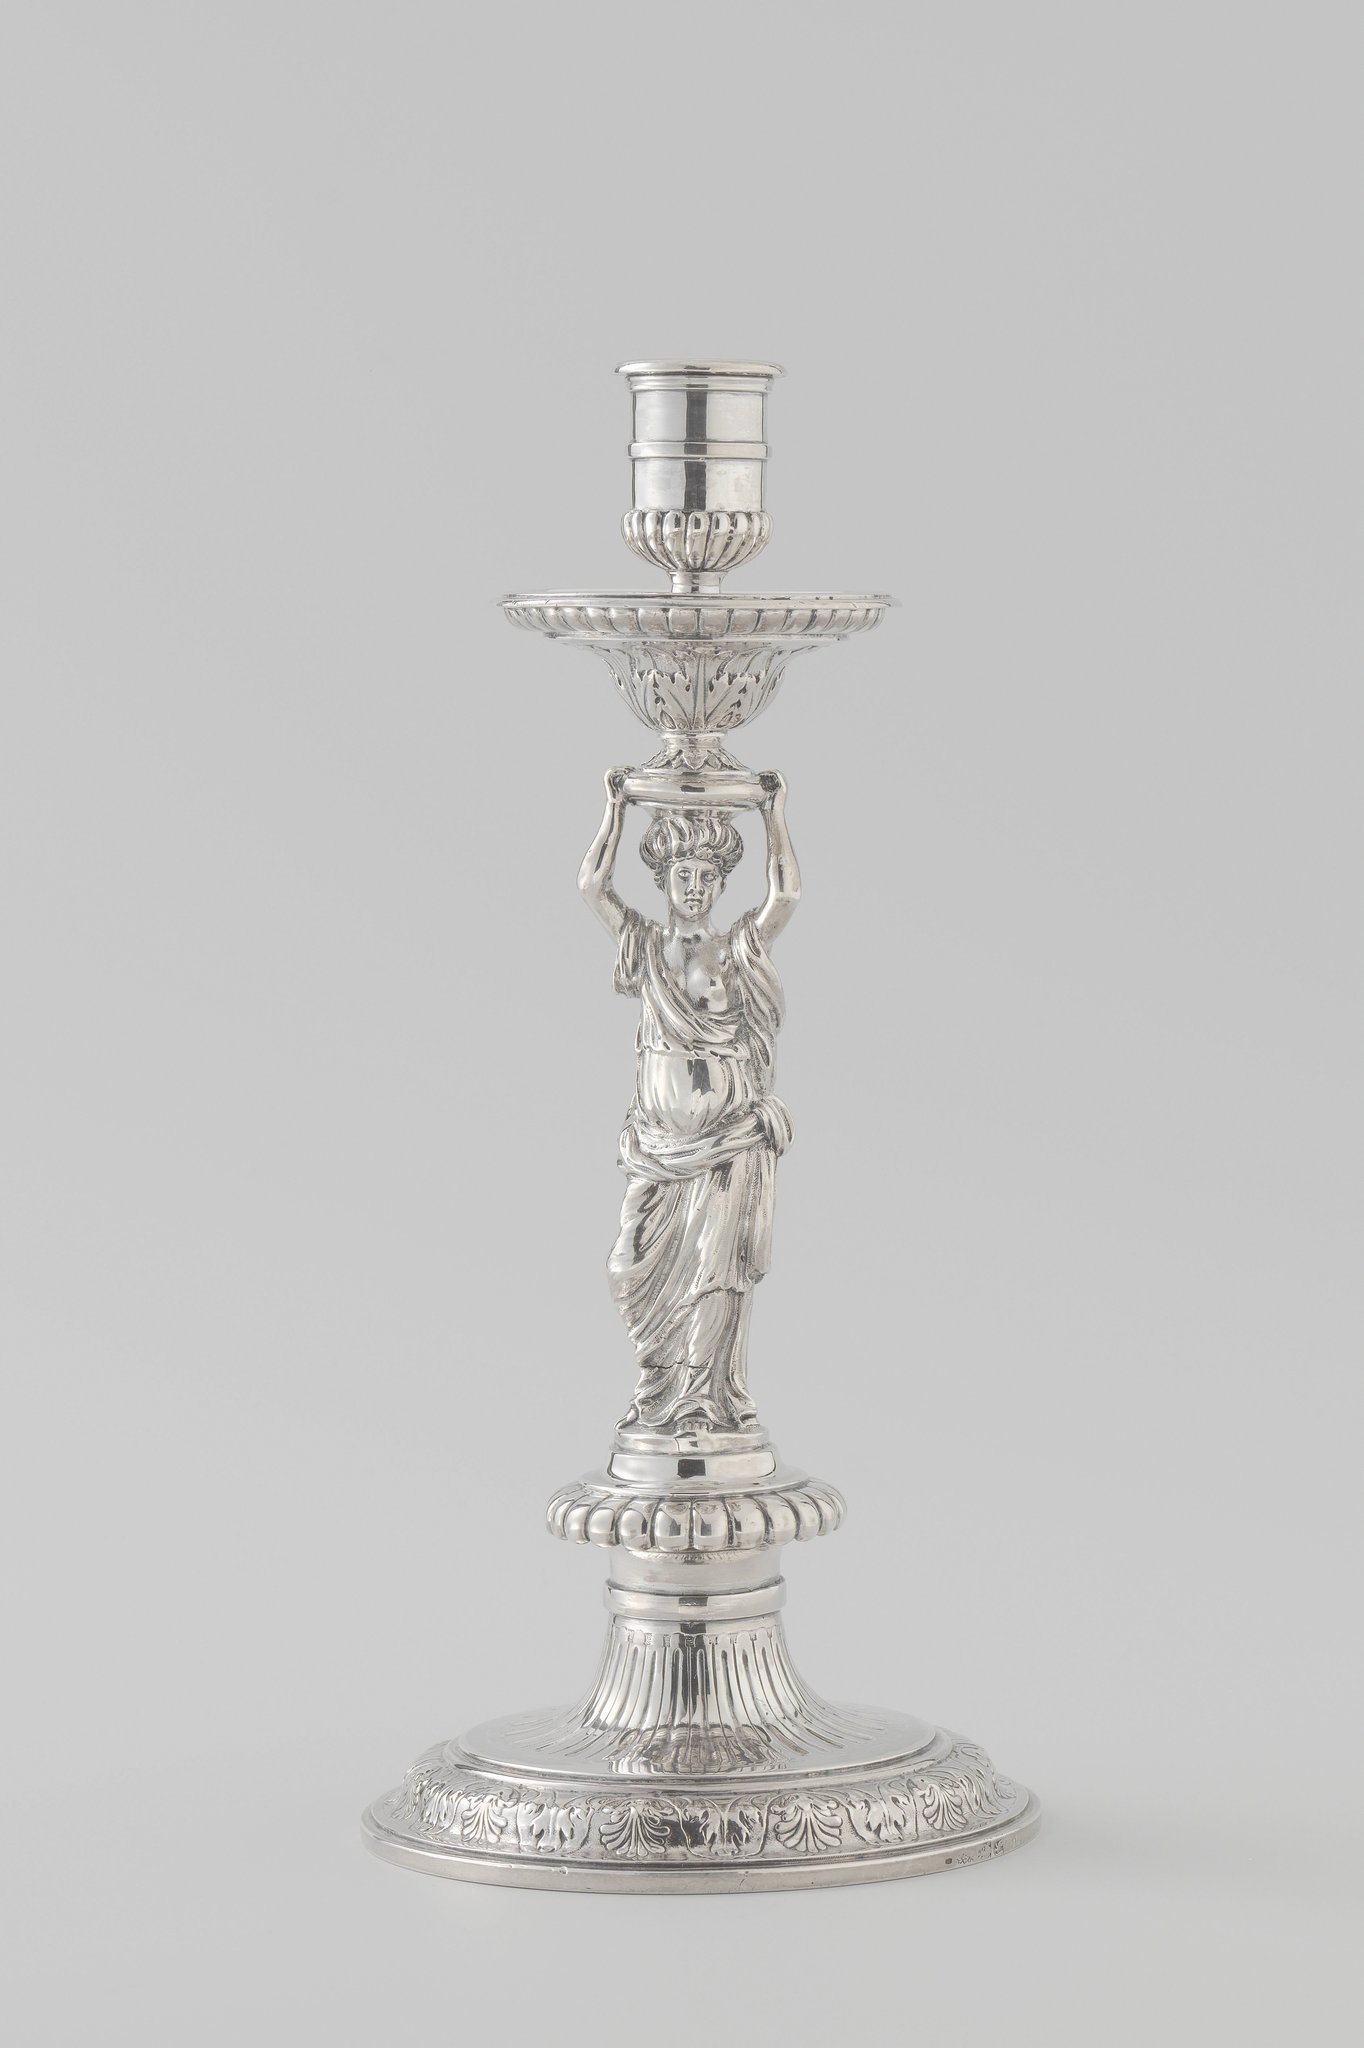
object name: candlestick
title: Two candlesticks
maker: adam loofs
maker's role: goldsmith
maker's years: 1645-1710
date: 1687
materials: silver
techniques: casting, metalworking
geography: the hague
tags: acanthus ~ ornament, carrying something on the head or on the shoulders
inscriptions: alloy mark, inscription: ‘W’, date letter: ‘N’, maker's mark, town mark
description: Adam Loofs was silversmith and silver steward to Stadtholder William III. After having worked for King Louis XIV in Paris, he moved to The Hague in 1680. These candlesticks may have been made for William III. They are based directly on the silver furnishings and other objects at Versailles.